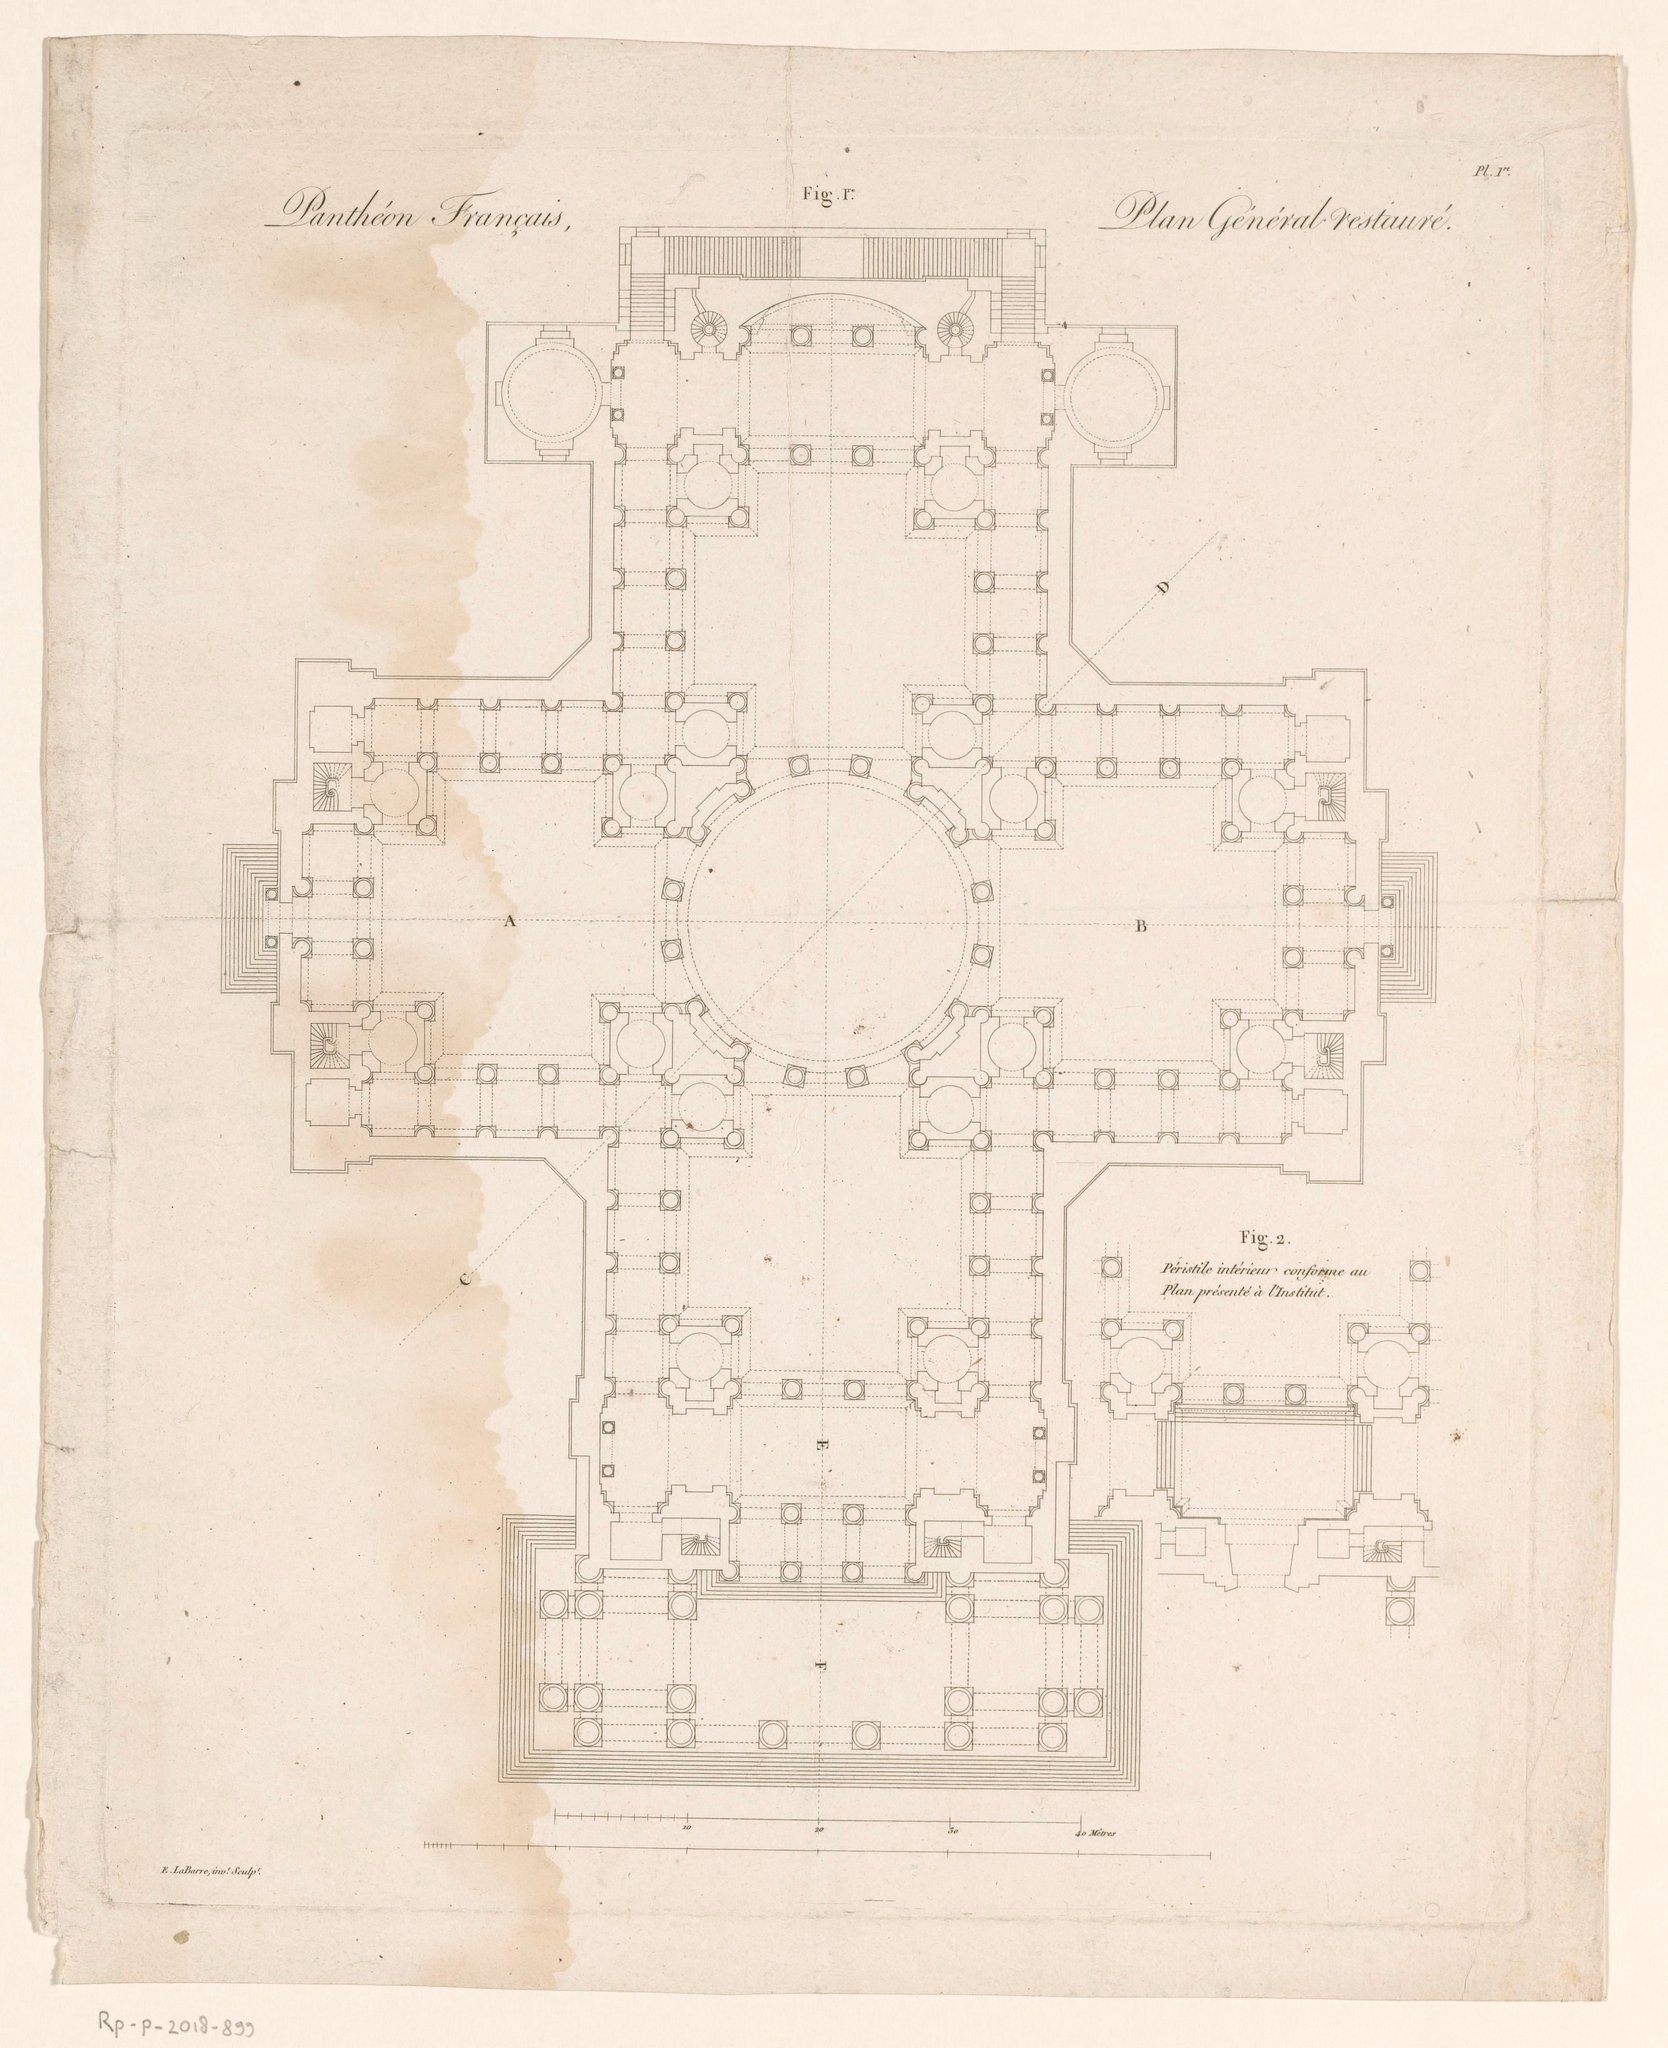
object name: area plan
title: Panthéon Français, plan genéral restauré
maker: étienne-éloy de la barre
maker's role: print maker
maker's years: 1764-1833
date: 1790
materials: paper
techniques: engraving, etching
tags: church (exterior), plan ~ architecture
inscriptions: collector's mark: Lugt 2228